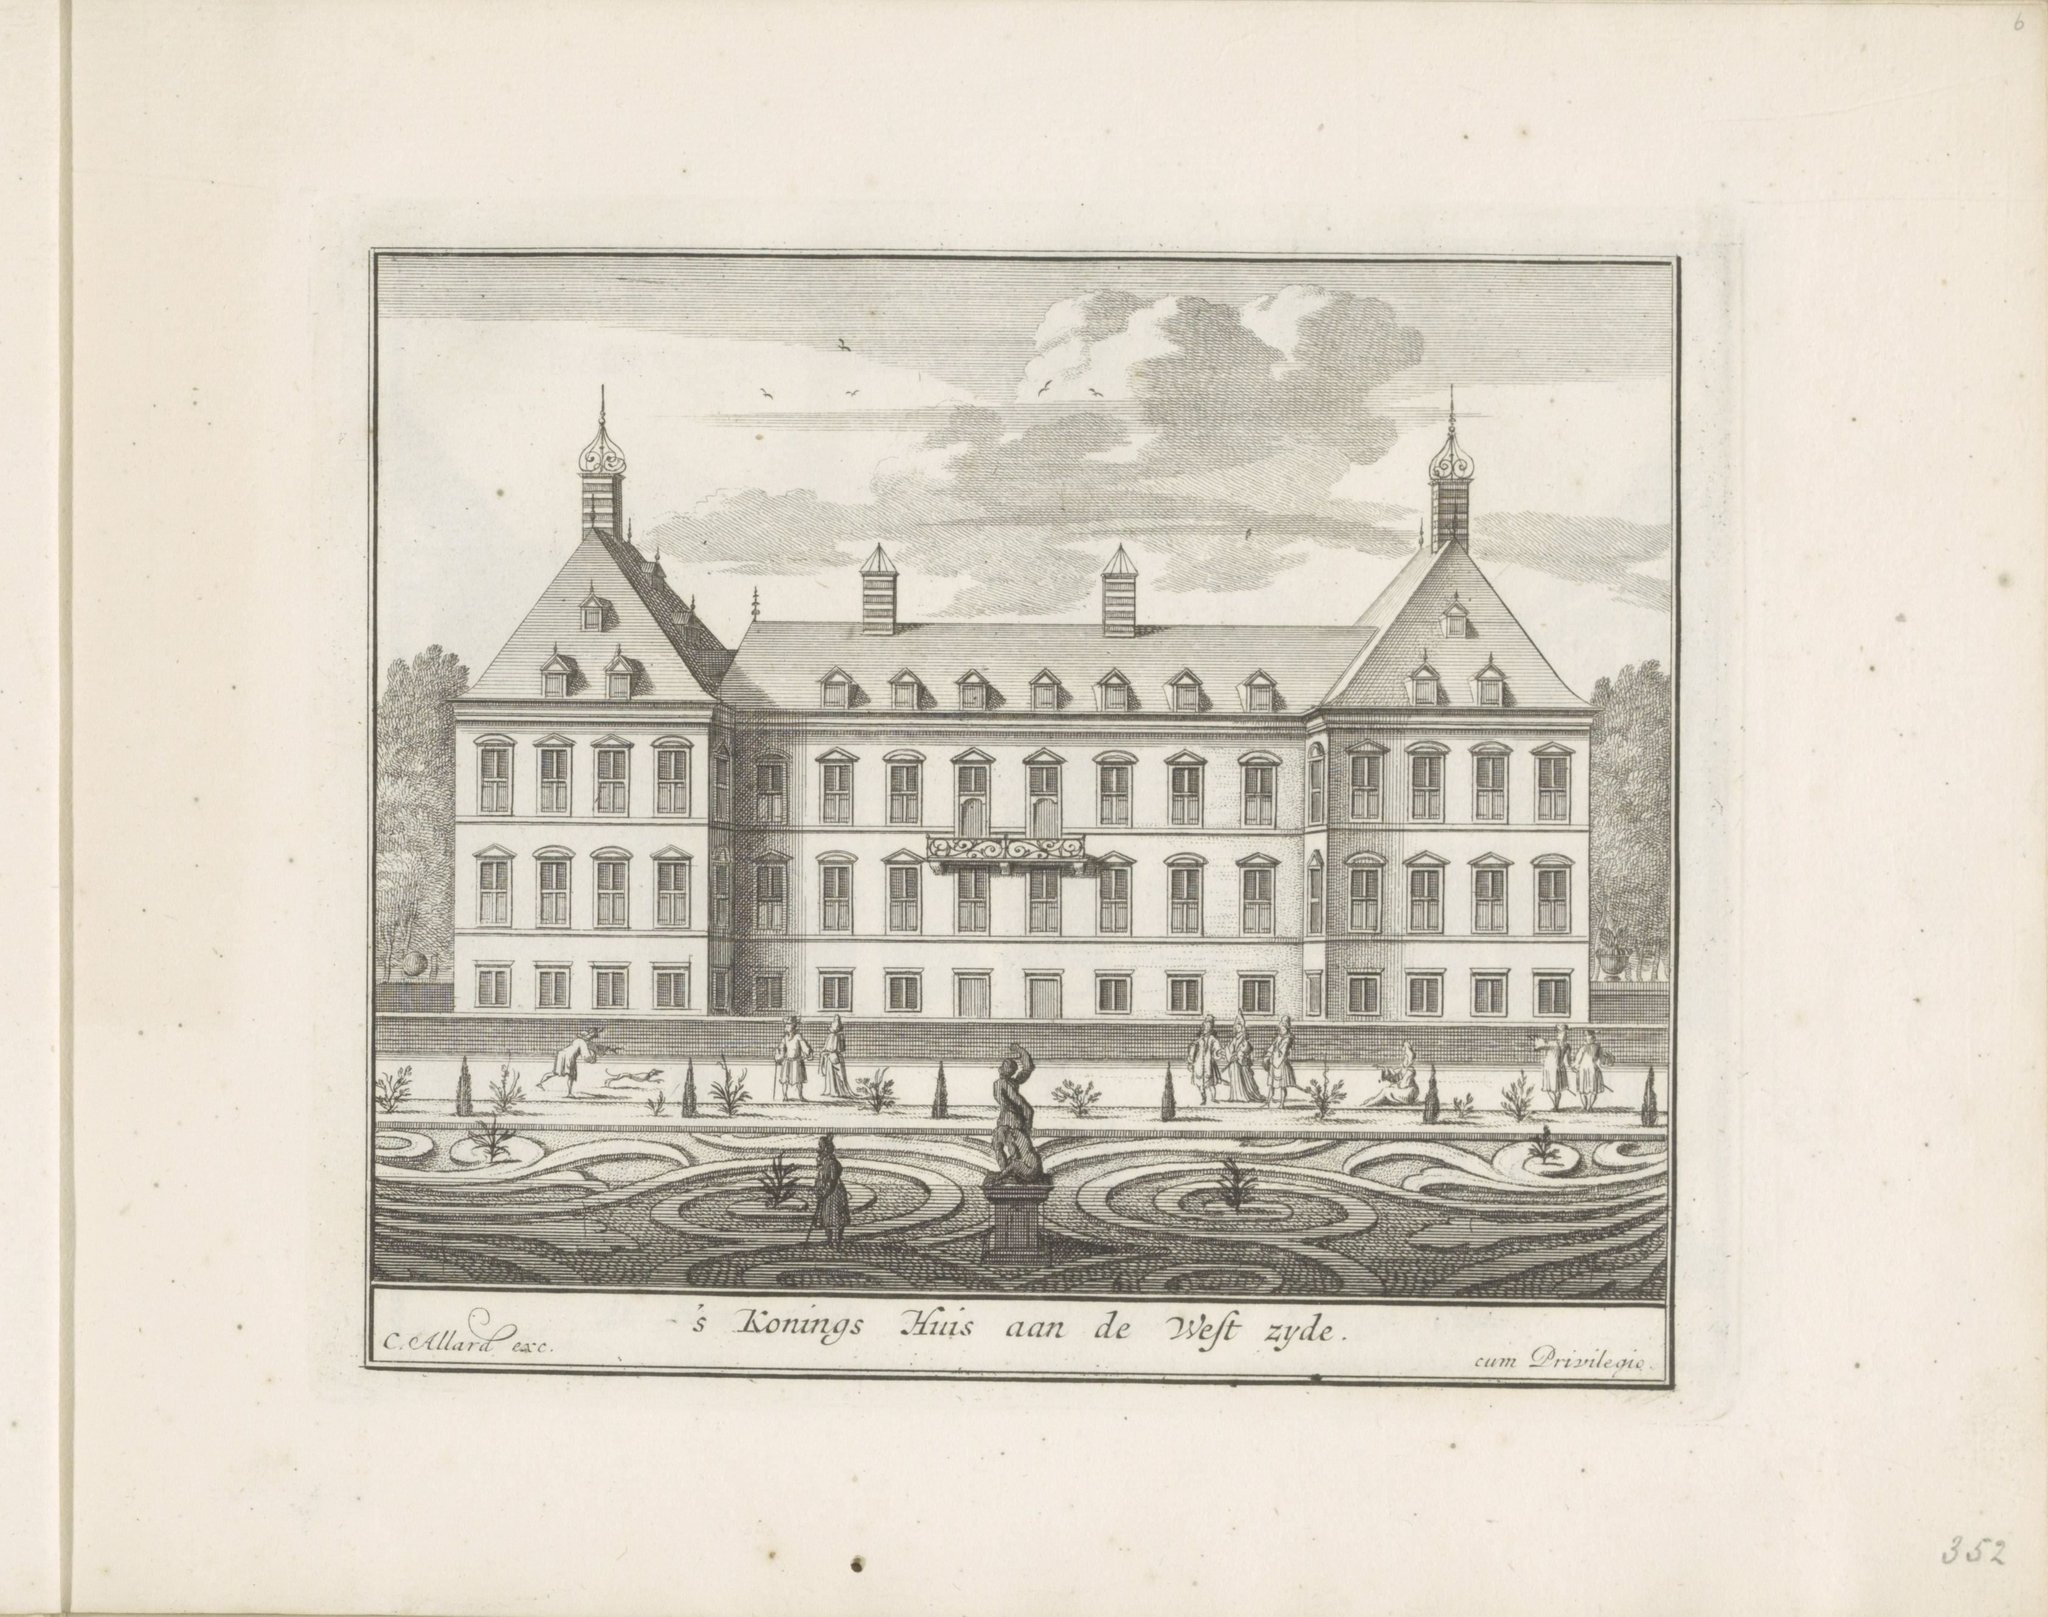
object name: album leaf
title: Hollands Lustpark besluitende zyn Britannische majesteits hof-gebouw tot Honslaardyk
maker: carel allard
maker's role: print maker, publisher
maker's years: 1648-1709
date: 1689-1702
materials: paper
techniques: etching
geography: amsterdam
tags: palace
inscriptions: number: ‘352’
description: Gezicht op Paleis Honselaarsdijk van de westzijde, voor het paleis ligt een barokke tuin en een laan met wandelaars. Prent maakt deel uit van een album.